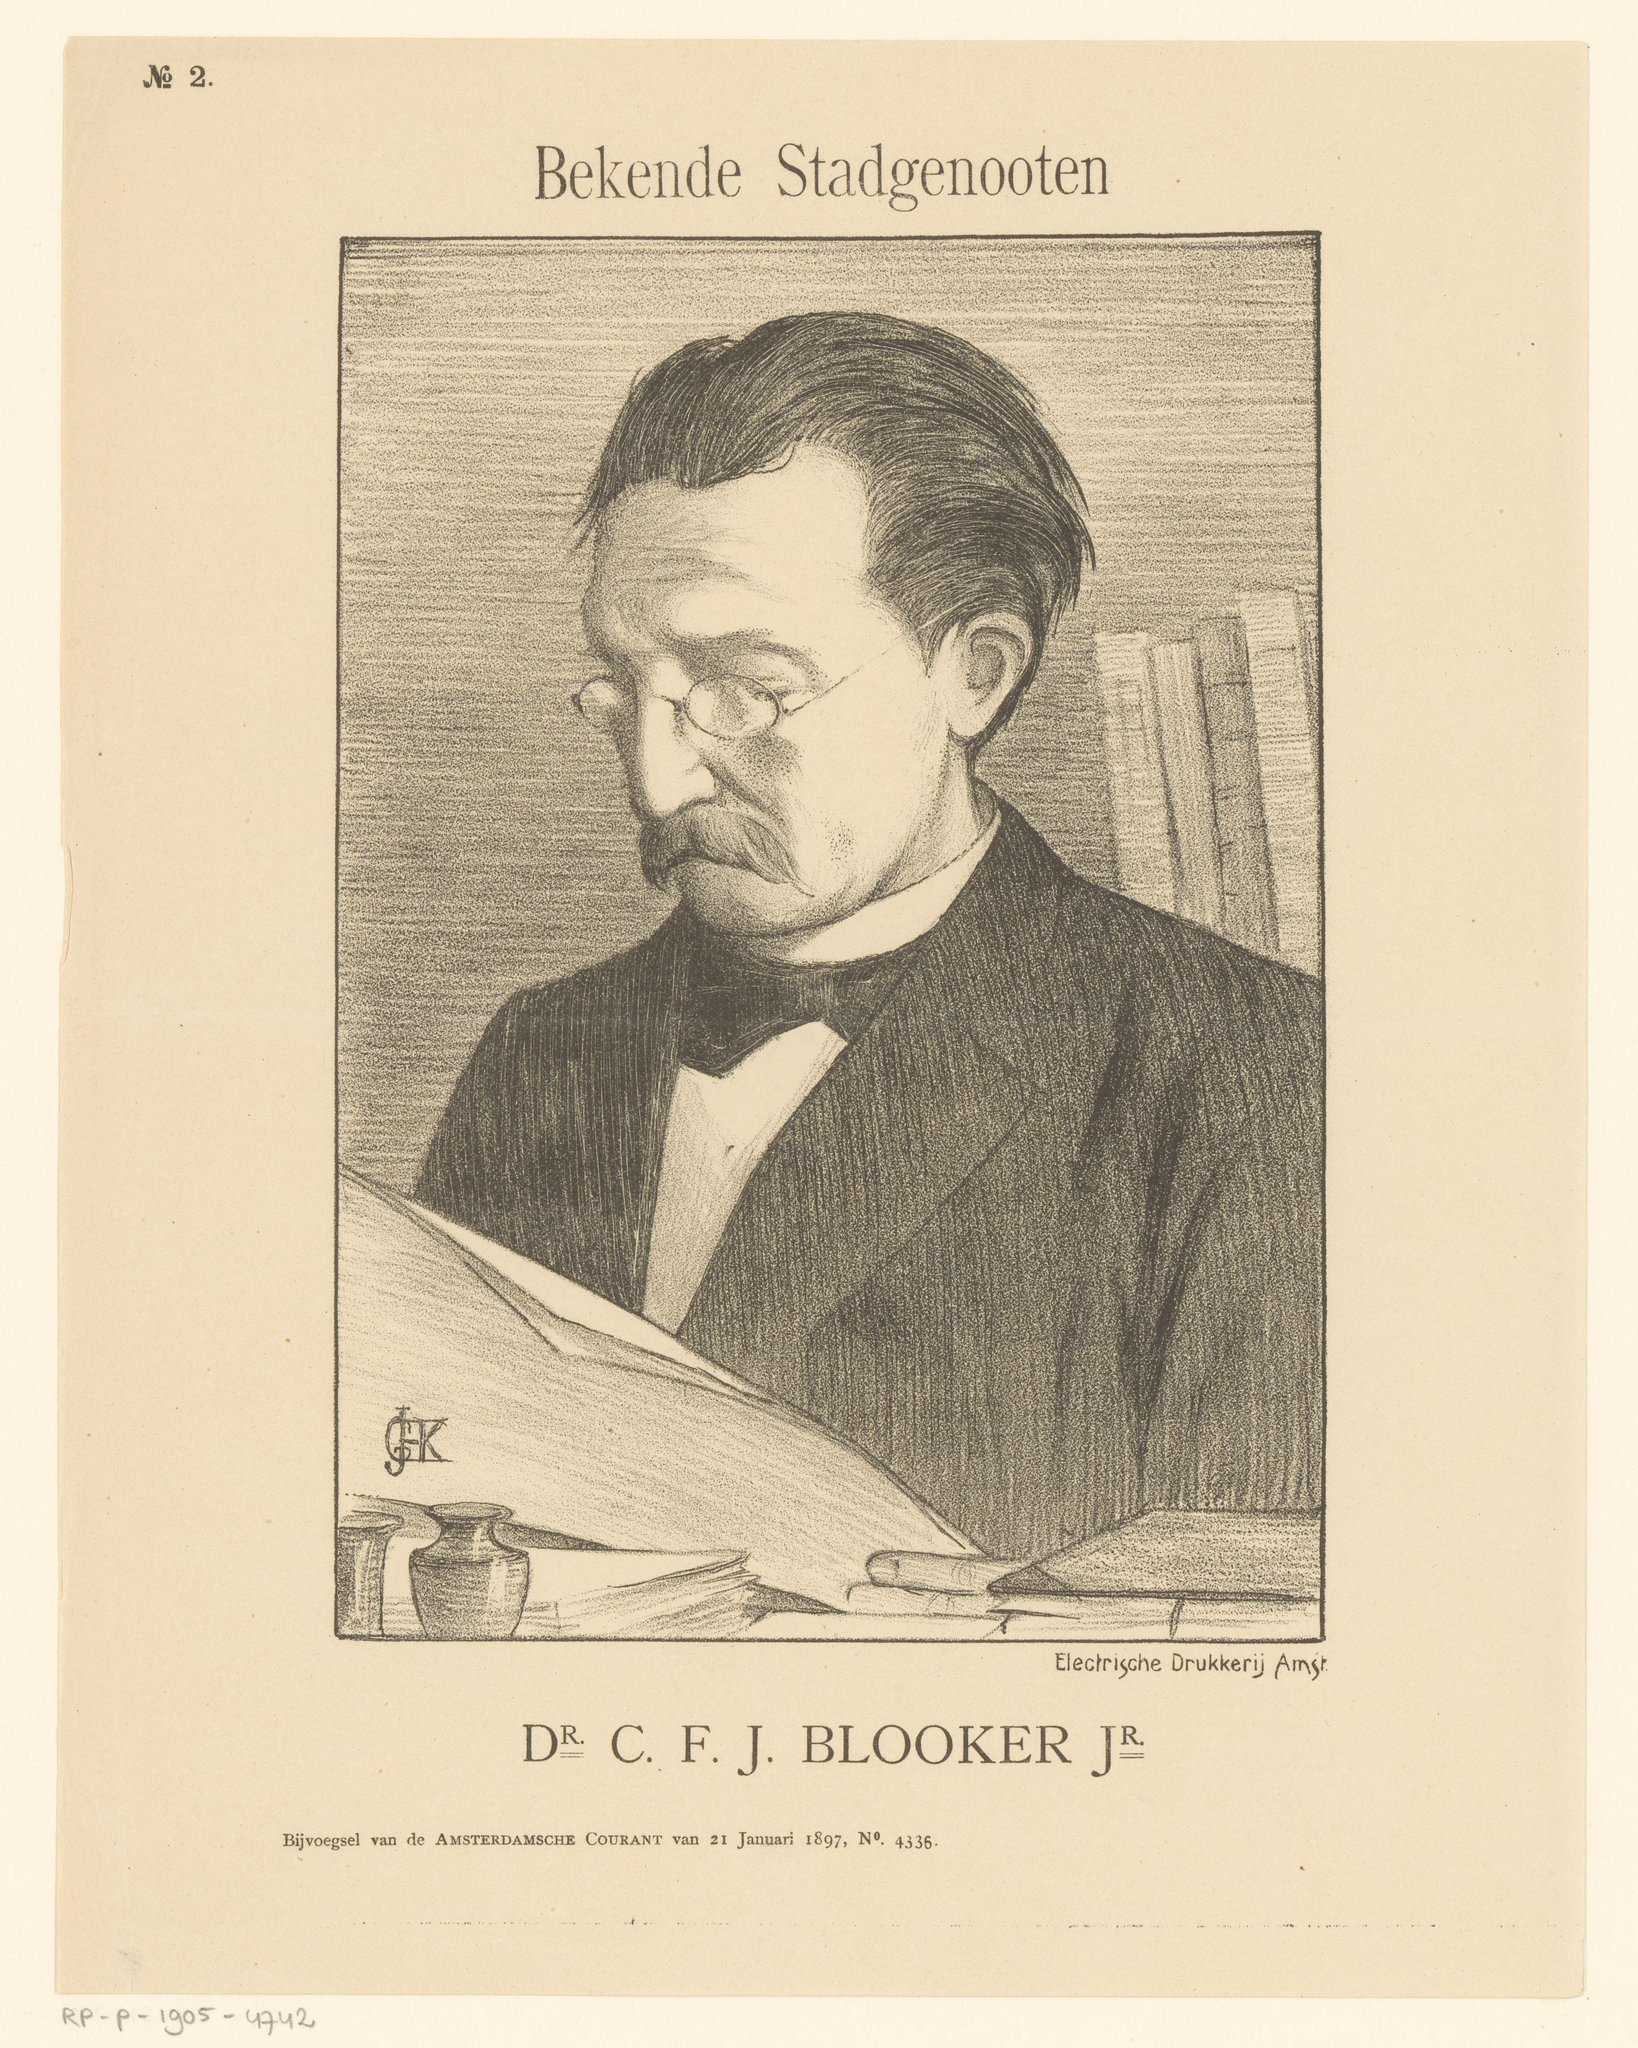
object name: print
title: Portret van Cornelis Frans Jacobus Blooker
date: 1897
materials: paper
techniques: lithograph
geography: amsterdam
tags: eyeglasses, spectacles, reading, historical persons (+ (full) bust portrait)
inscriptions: collector's mark: Lugt 2228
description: De geportretteerde draagt een bril en leest van een vel papier. Achter hem staat een rij boeken. Genummerd linksboven: No. 2. Onder het portret: "Bijvoegsel van de Amsterdamsche Courant van 21 Januari 1897, No. 4336."